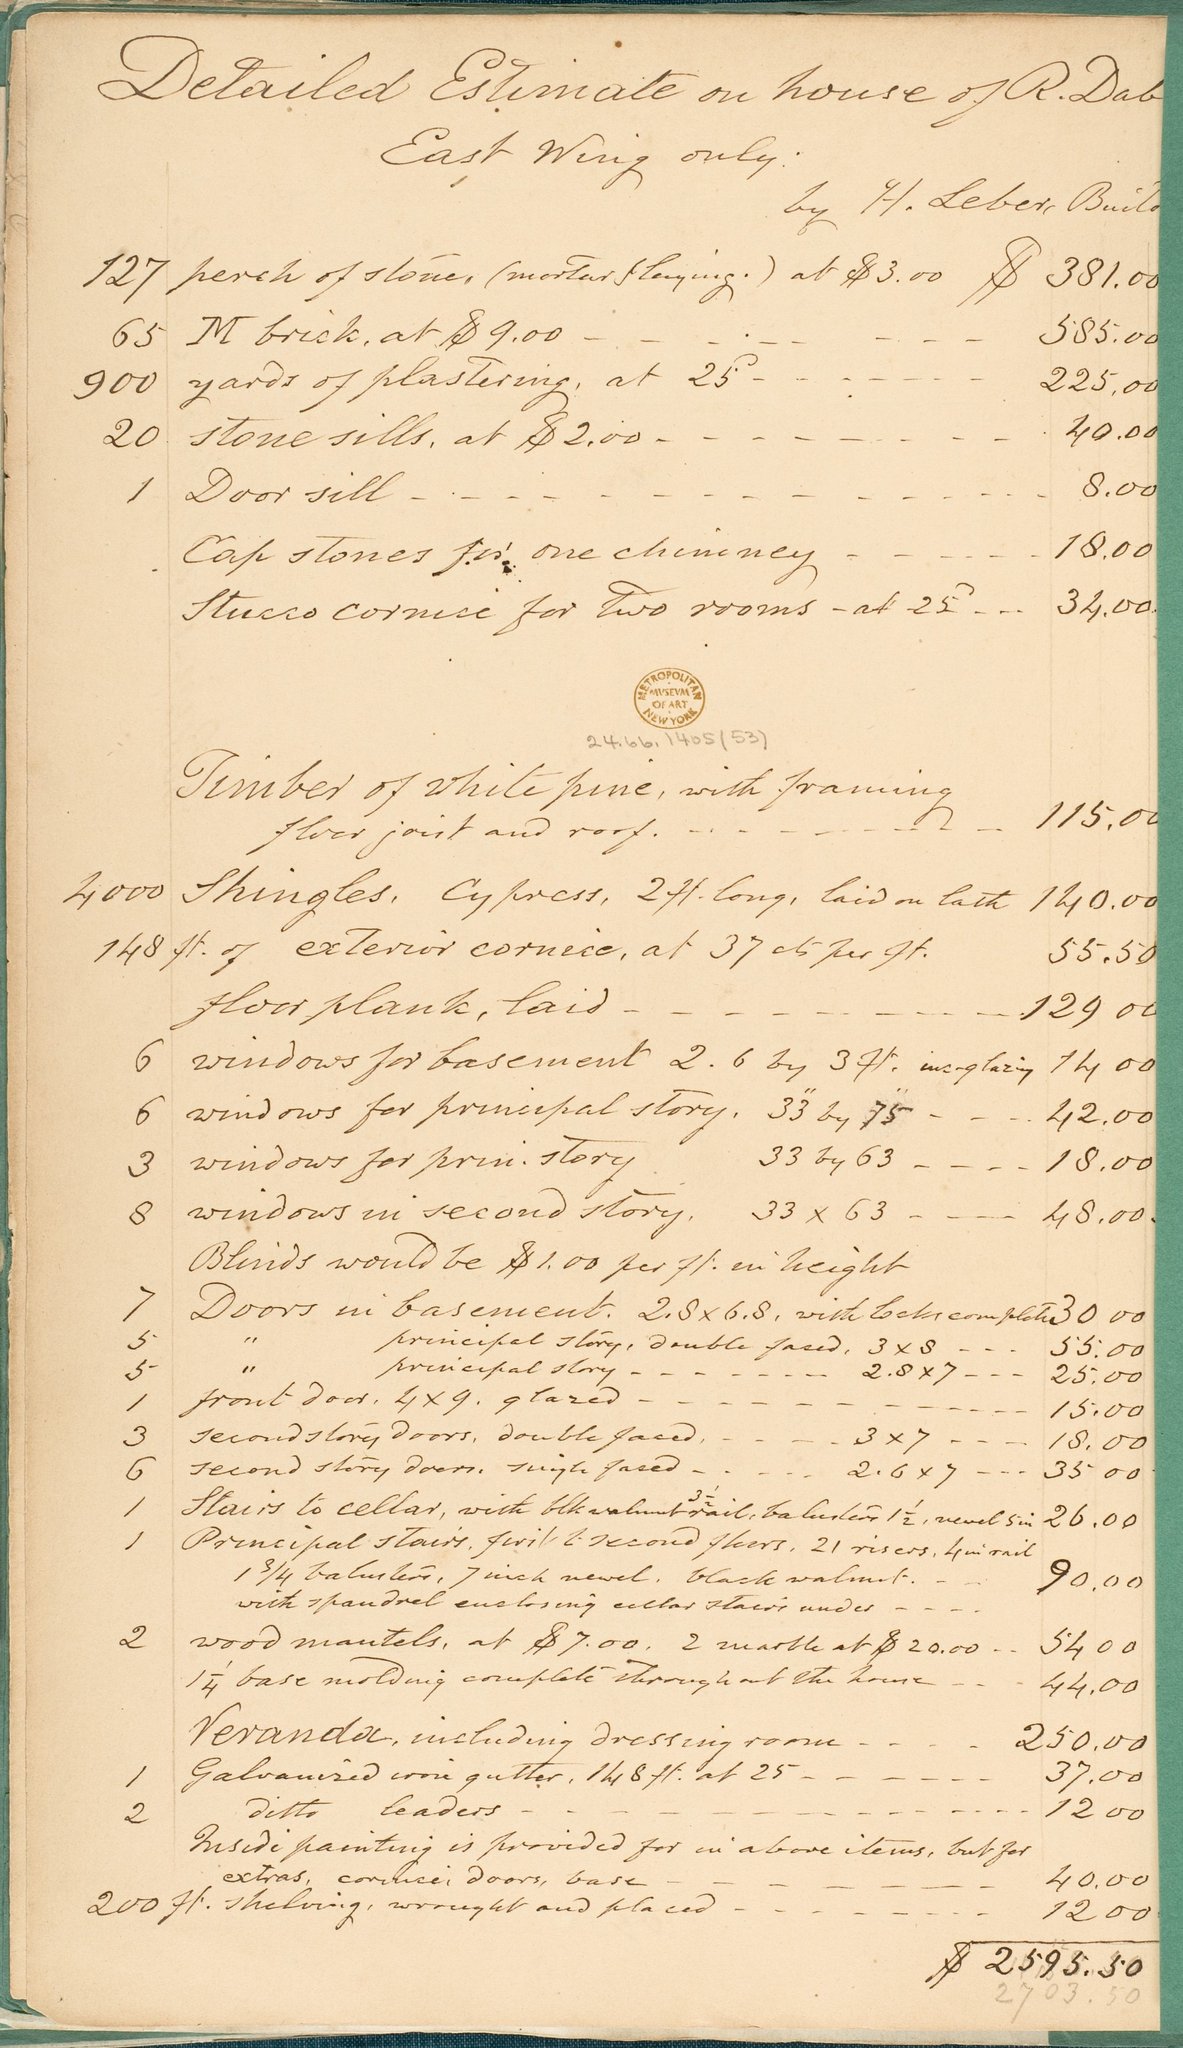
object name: manuscript ornament architecture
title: Detailed Estimate on House of R. Dabney, Powhatan, Virginia, East Wing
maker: alexander jackson davis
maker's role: artist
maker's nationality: american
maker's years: 1803-1892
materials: ink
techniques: wash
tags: documents